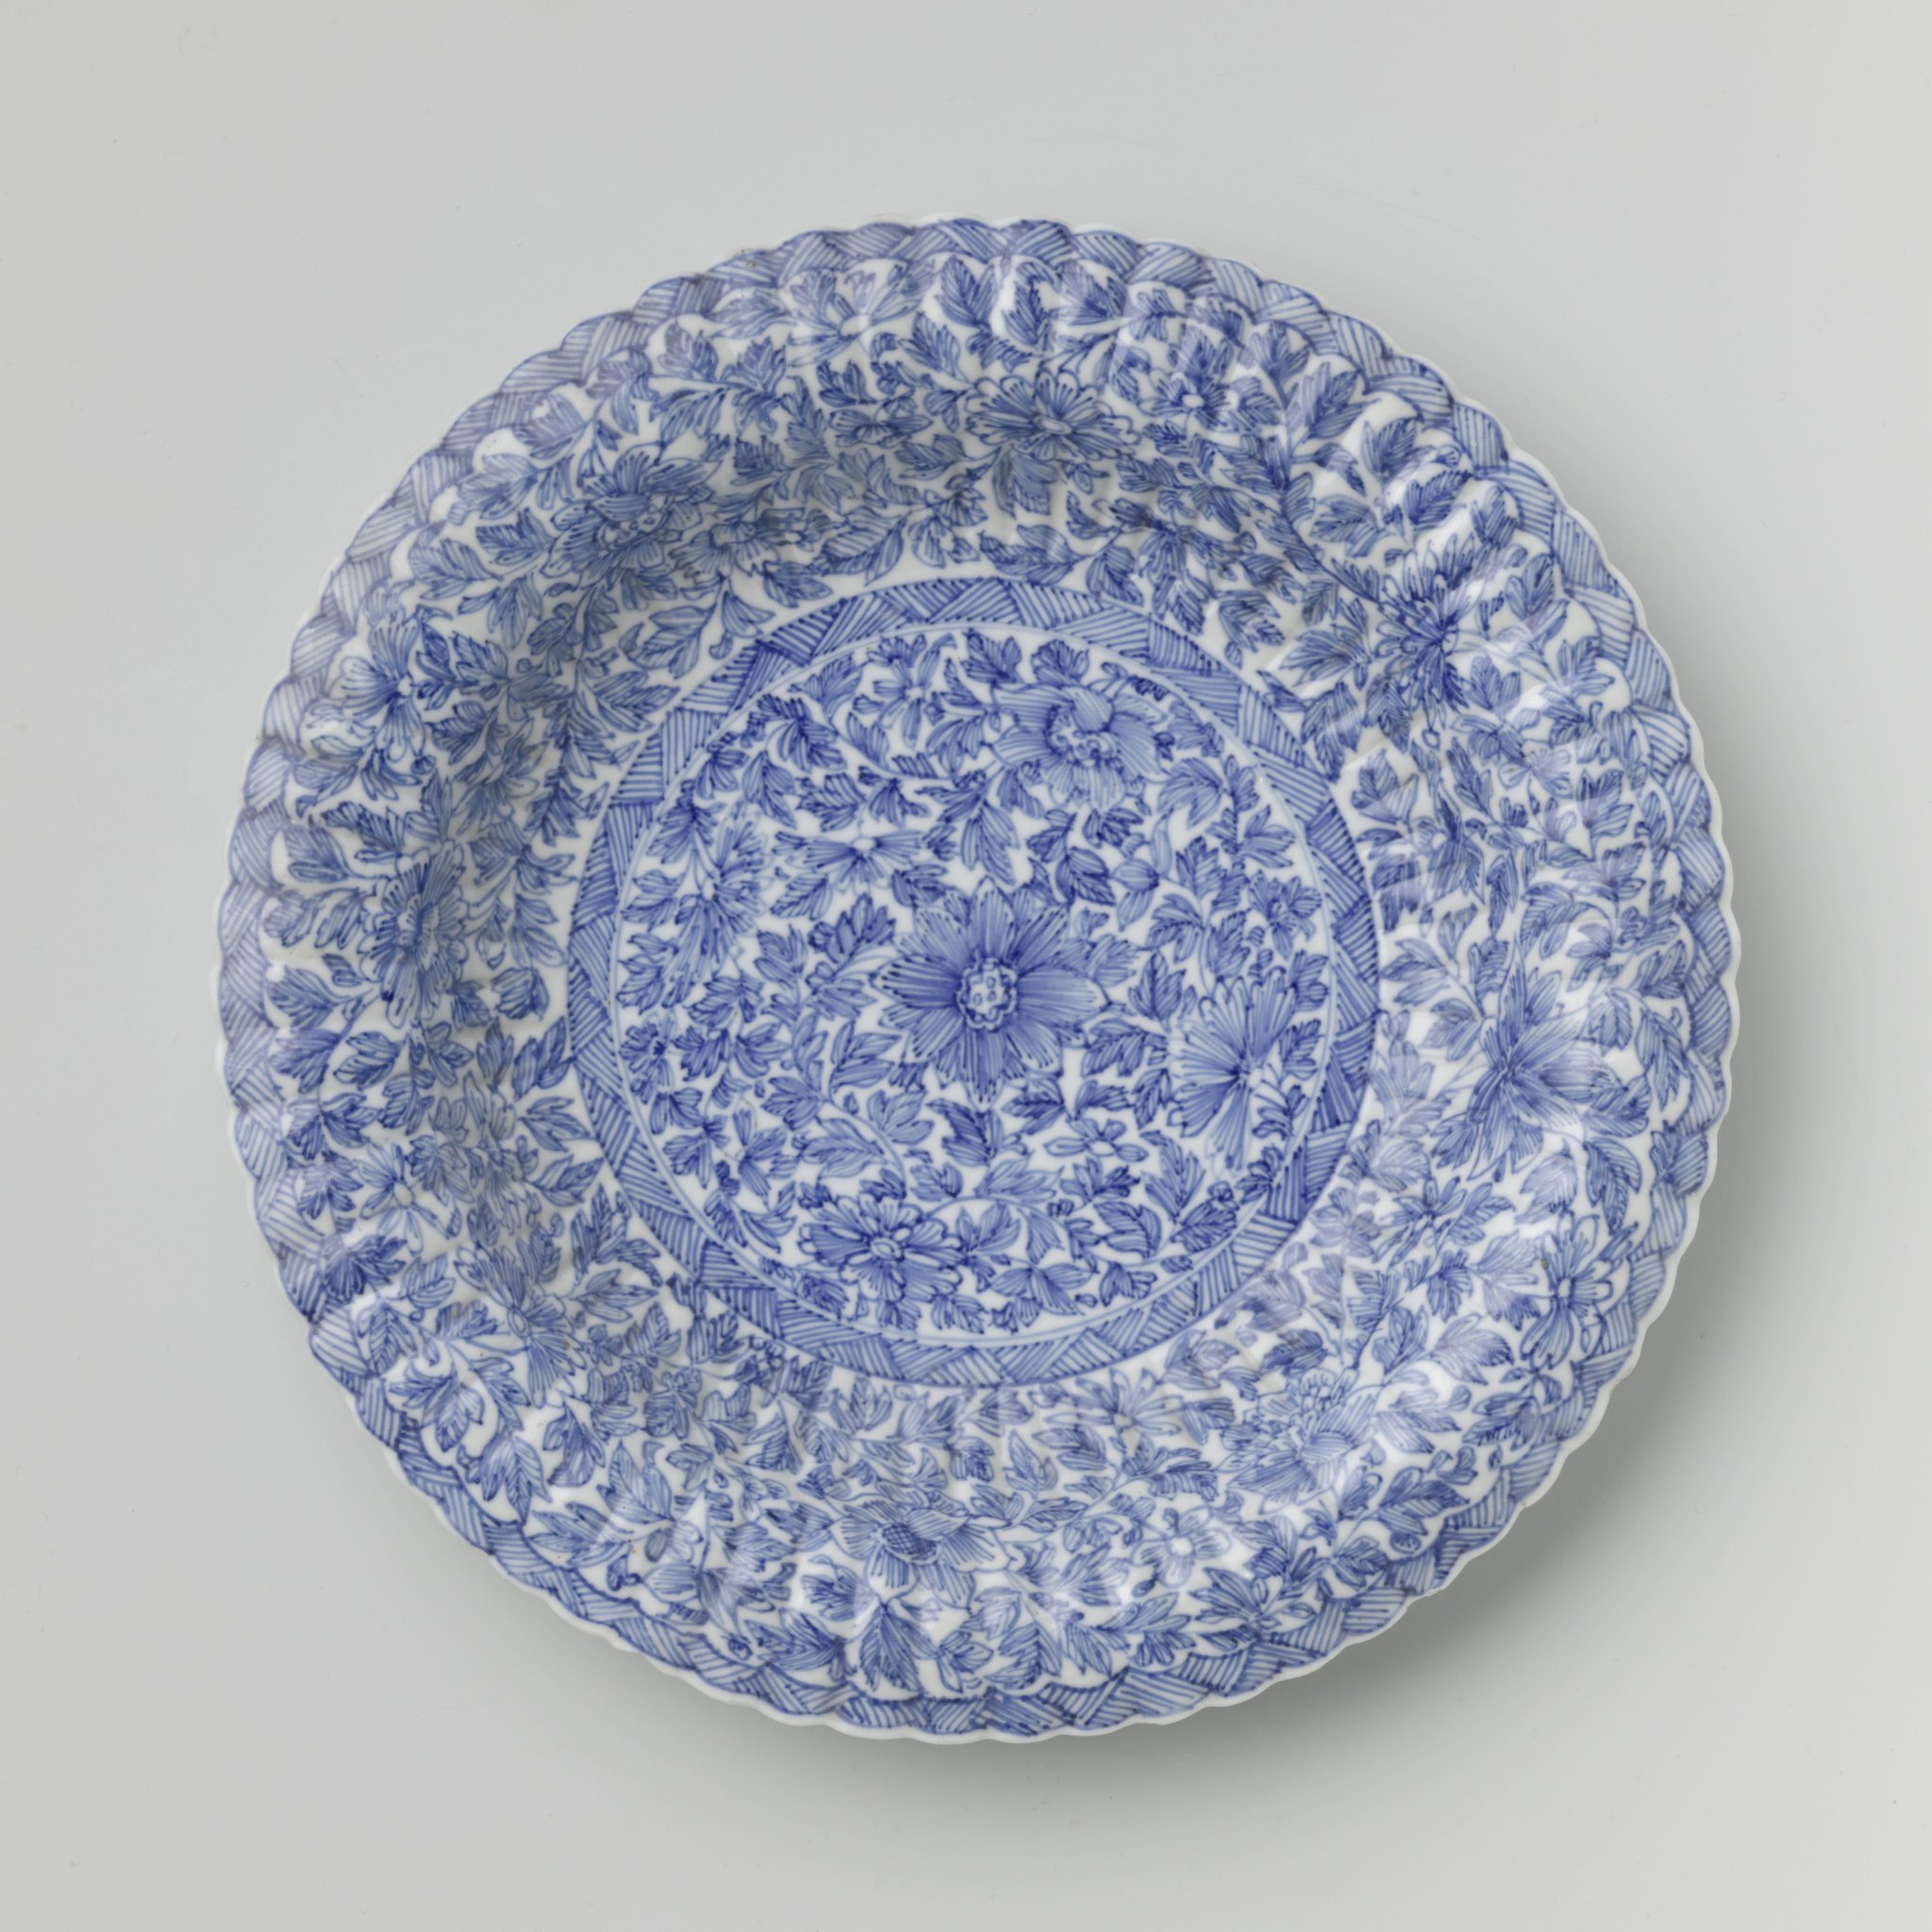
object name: plate dish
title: Plate with fluted sides and continuous flower pattern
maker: Anonymous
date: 1700-1724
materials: cobalt, glaze, paint, porcelain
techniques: firing, forming, turning, vitrification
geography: china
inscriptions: mark